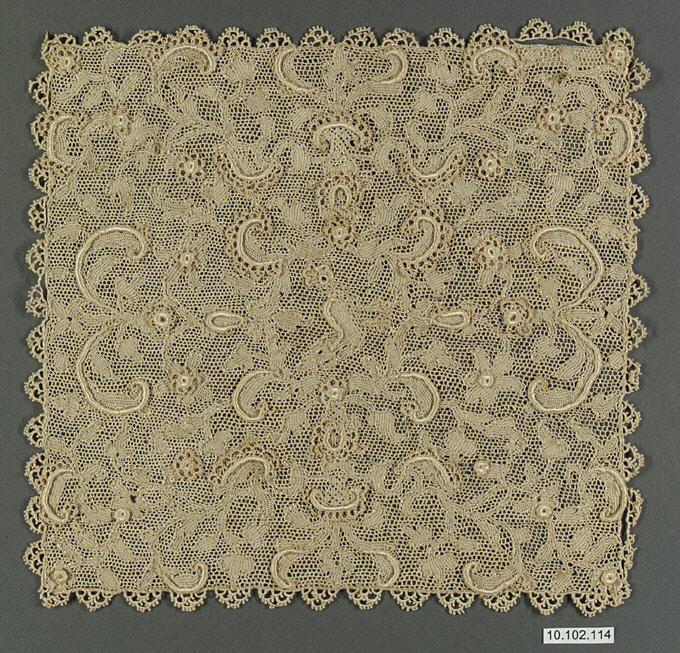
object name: square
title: Square (one of four)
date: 1701-1800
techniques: lace